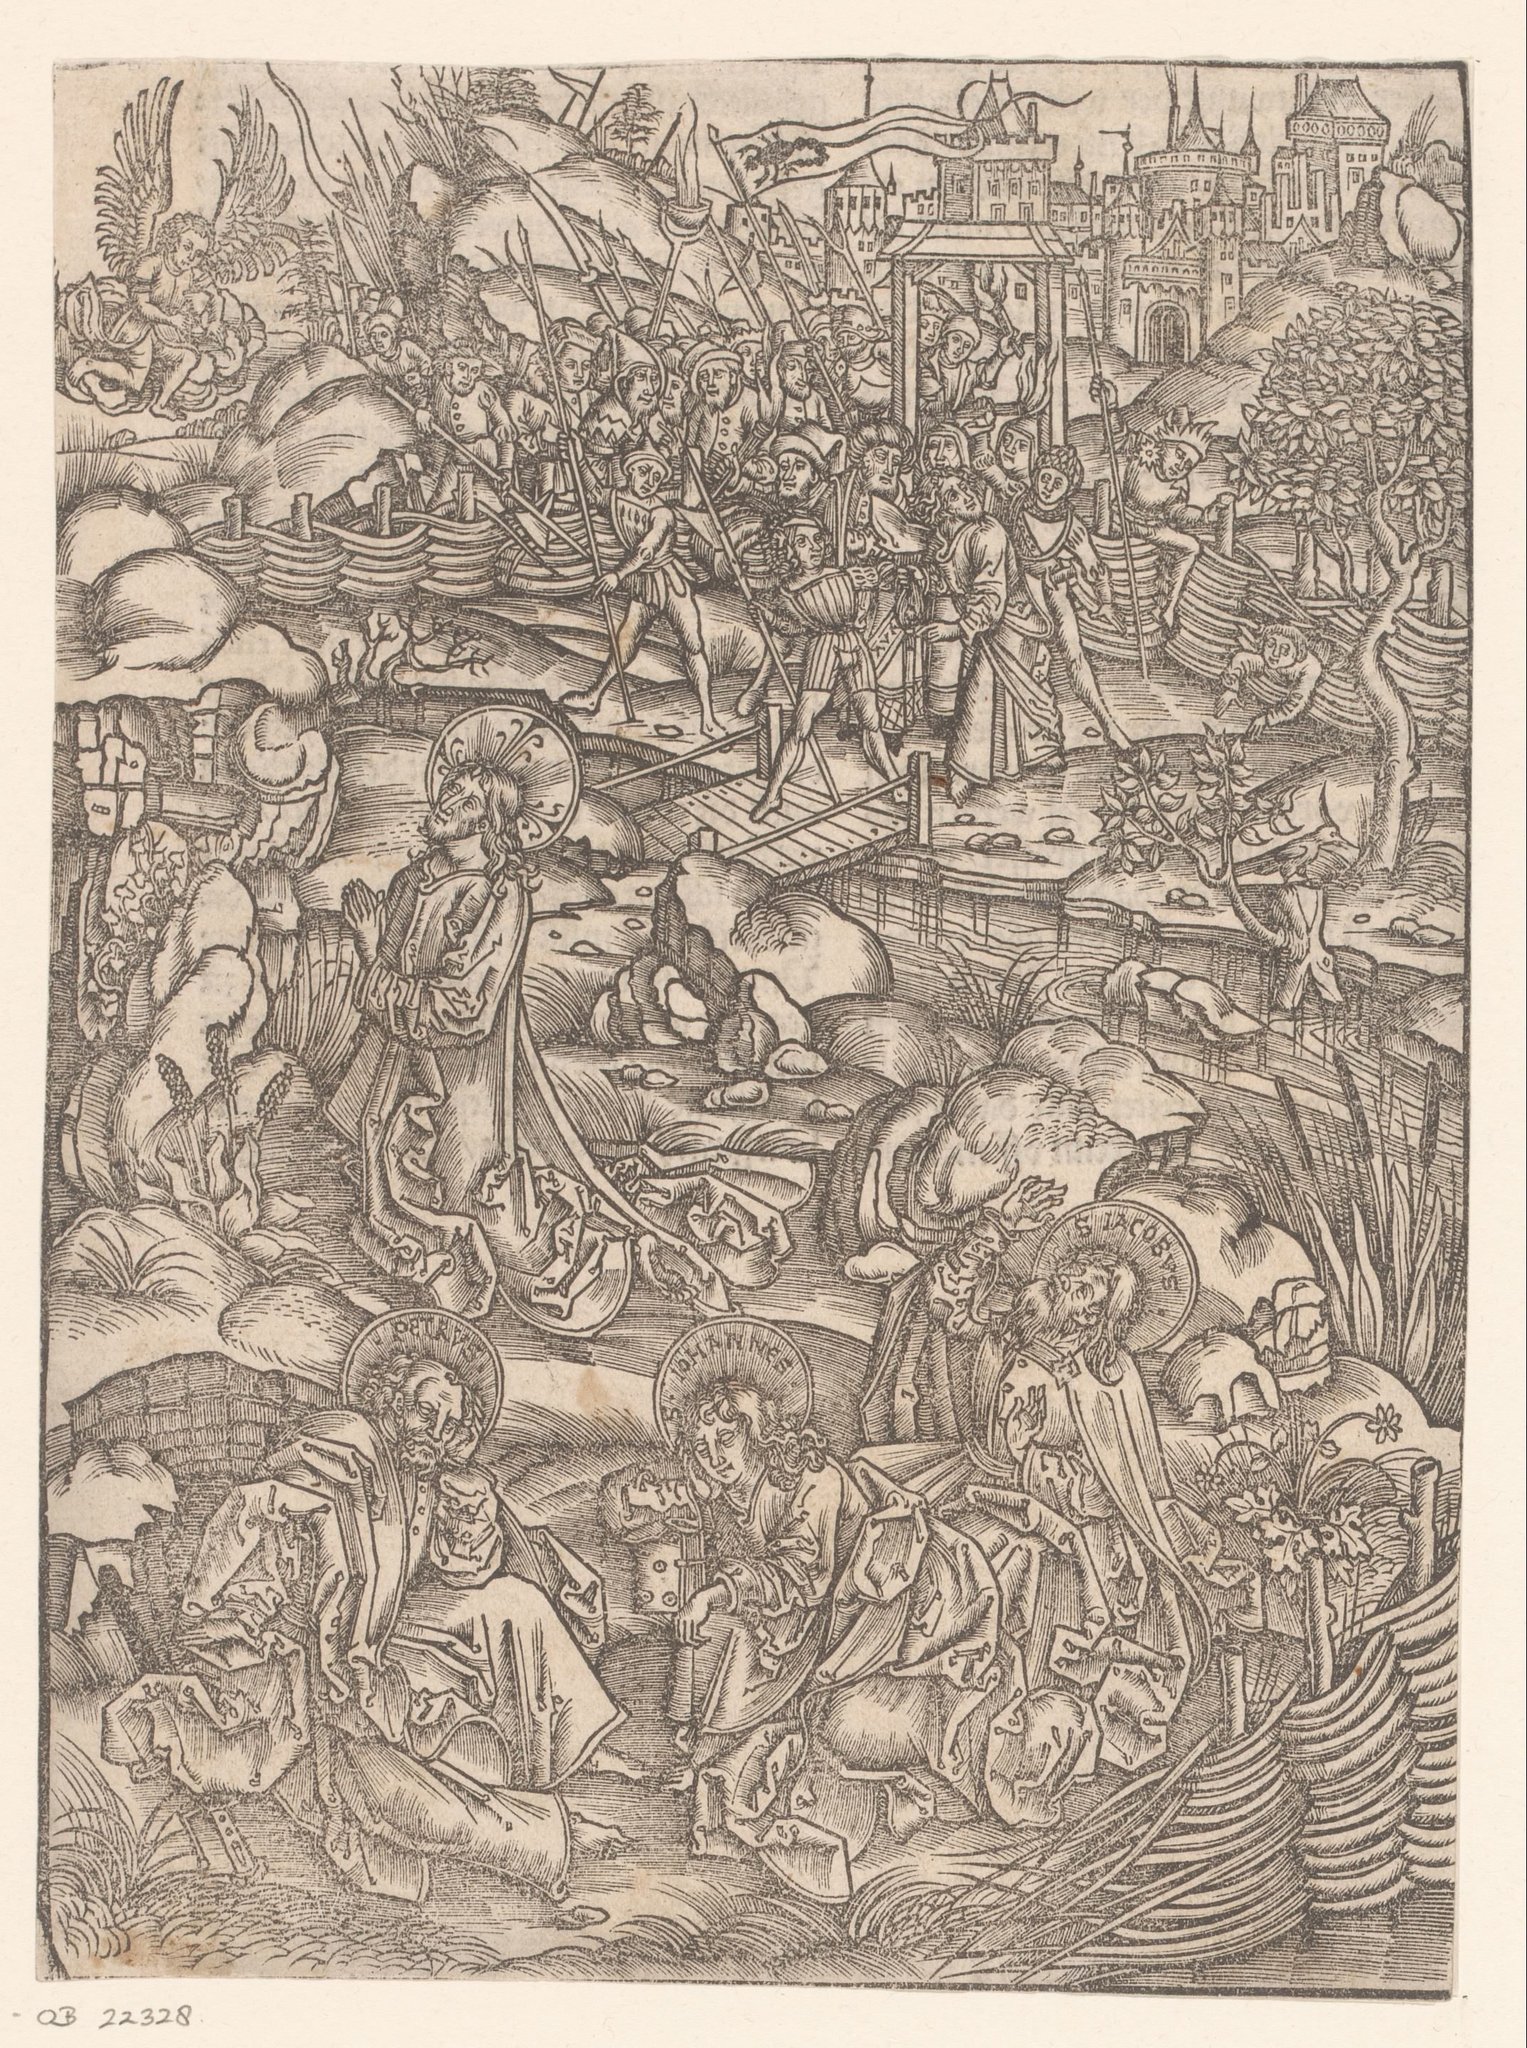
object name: print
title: Christus in de hof van Getsemane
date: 1502-1510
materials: paper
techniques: woodcut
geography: straatsburg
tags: christ's prayer in the garden of gethsemane during the night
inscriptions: collector's mark: Lugt 240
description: Illustraties waarschijnlijk afkomstig uit: Der heilige leben (...). Straatsburg: Johann Grüninger, 1502 of 1510.